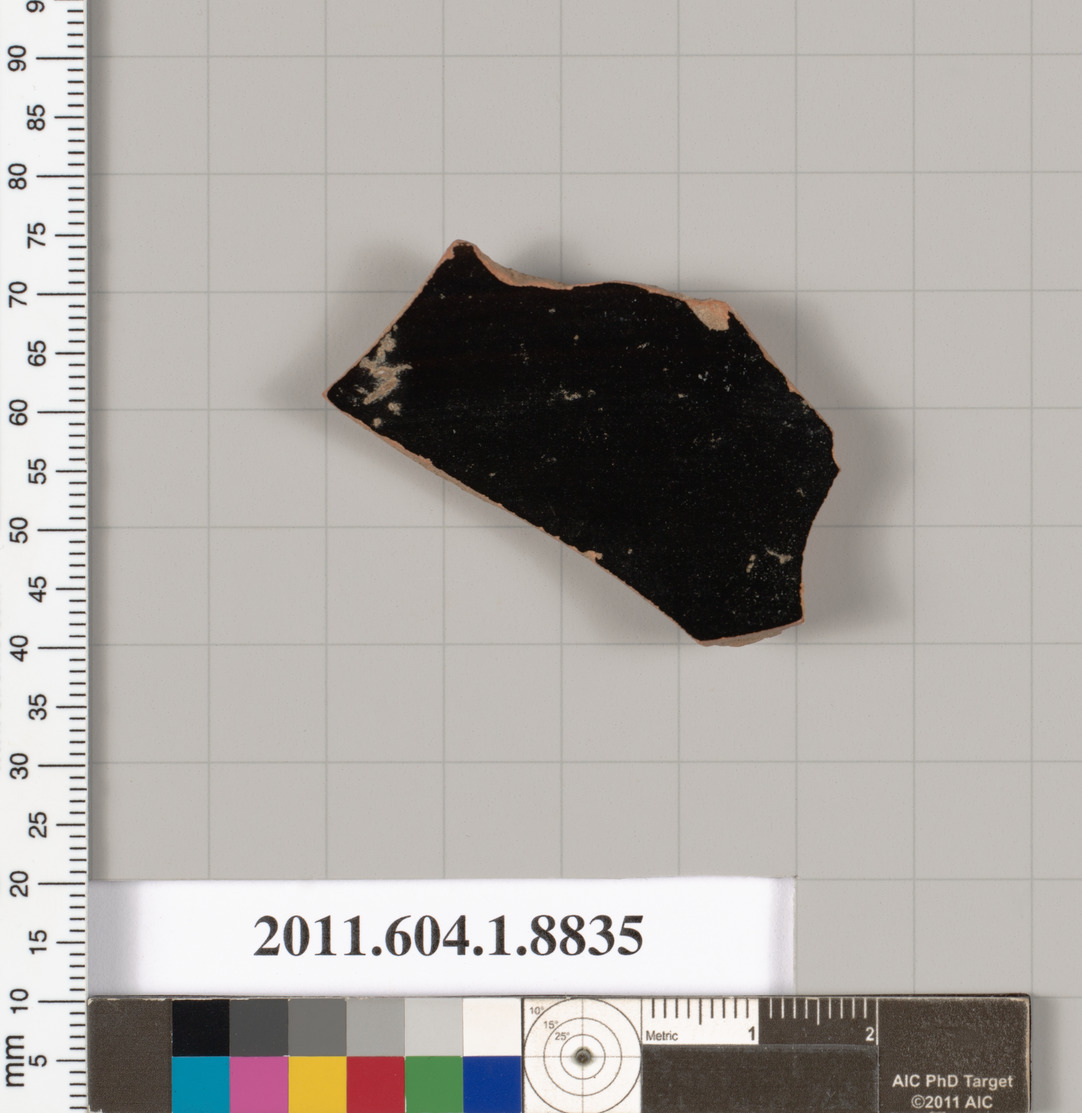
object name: kylix fragment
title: Terracotta fragment of a kylix (drinking cup)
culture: greek, attic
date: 490-470 BCE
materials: terracotta